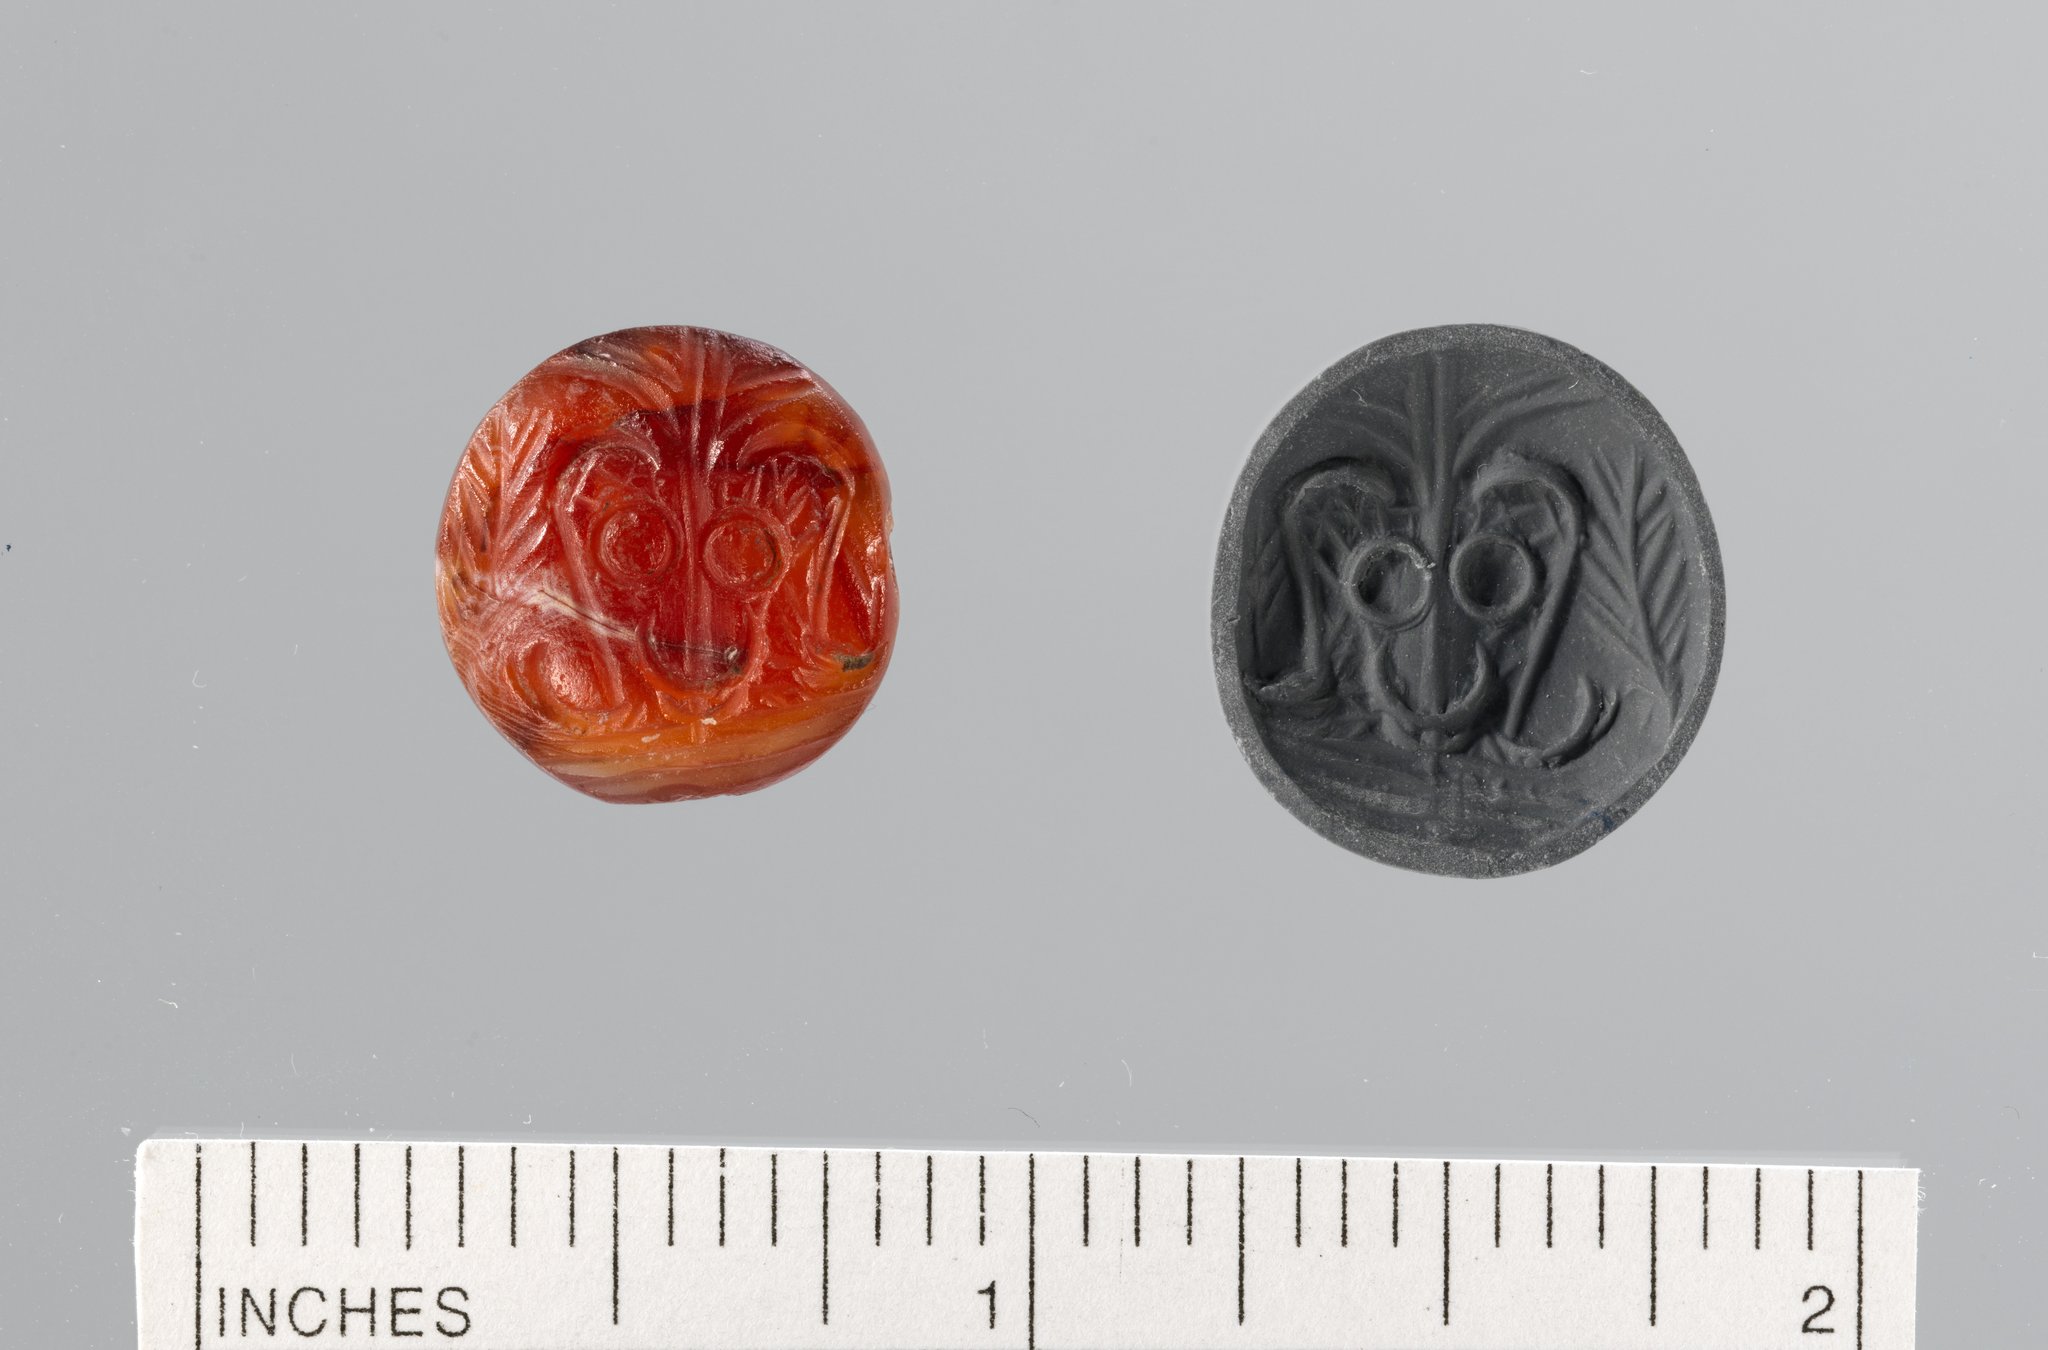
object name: seal, lentoid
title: Carnelian Lentoid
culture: minoan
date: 1650-1500 BCE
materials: gemstone